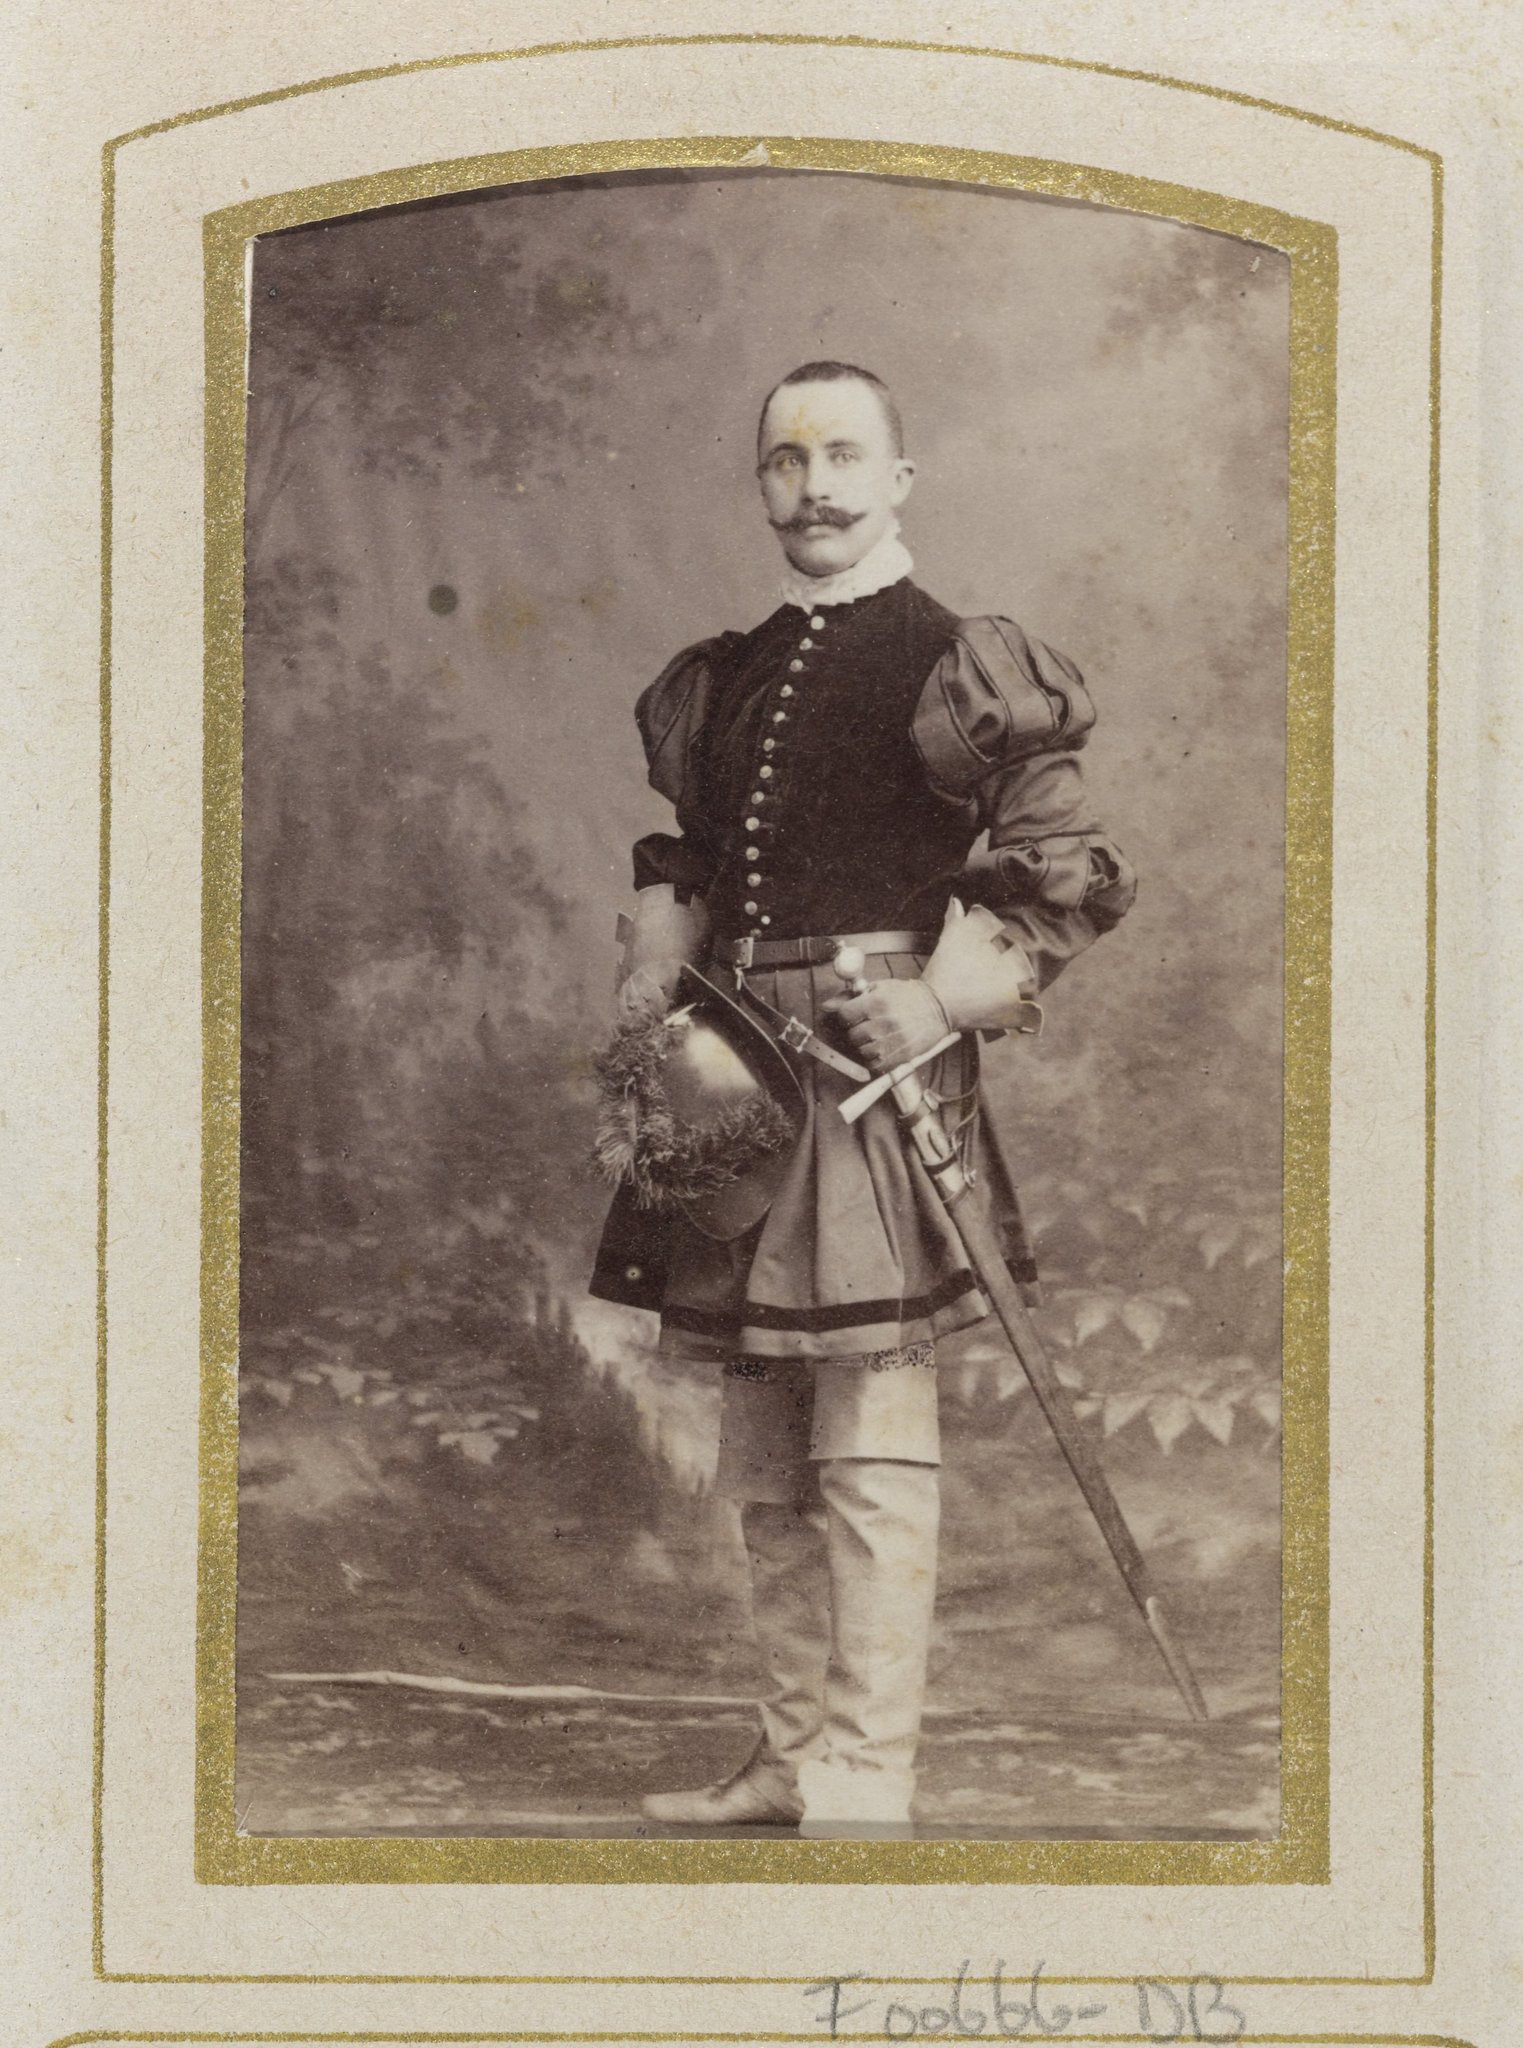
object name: album leaf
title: Portret van een jonge man in kostuum met zwaard, aangeduid als B.J.D. Zubli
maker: e. visser von weeren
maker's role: fotograaf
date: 1850-1900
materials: cardboard, photographic support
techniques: albumen print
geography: the hague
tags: historical persons, hacking and thrusting weapons: sword, historical costume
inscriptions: inscription: ‘Visser v. Weeren/ La Haye/ Piet Heinstraat 39.’, name: ‘B. J. D. Zubli./ 258.’